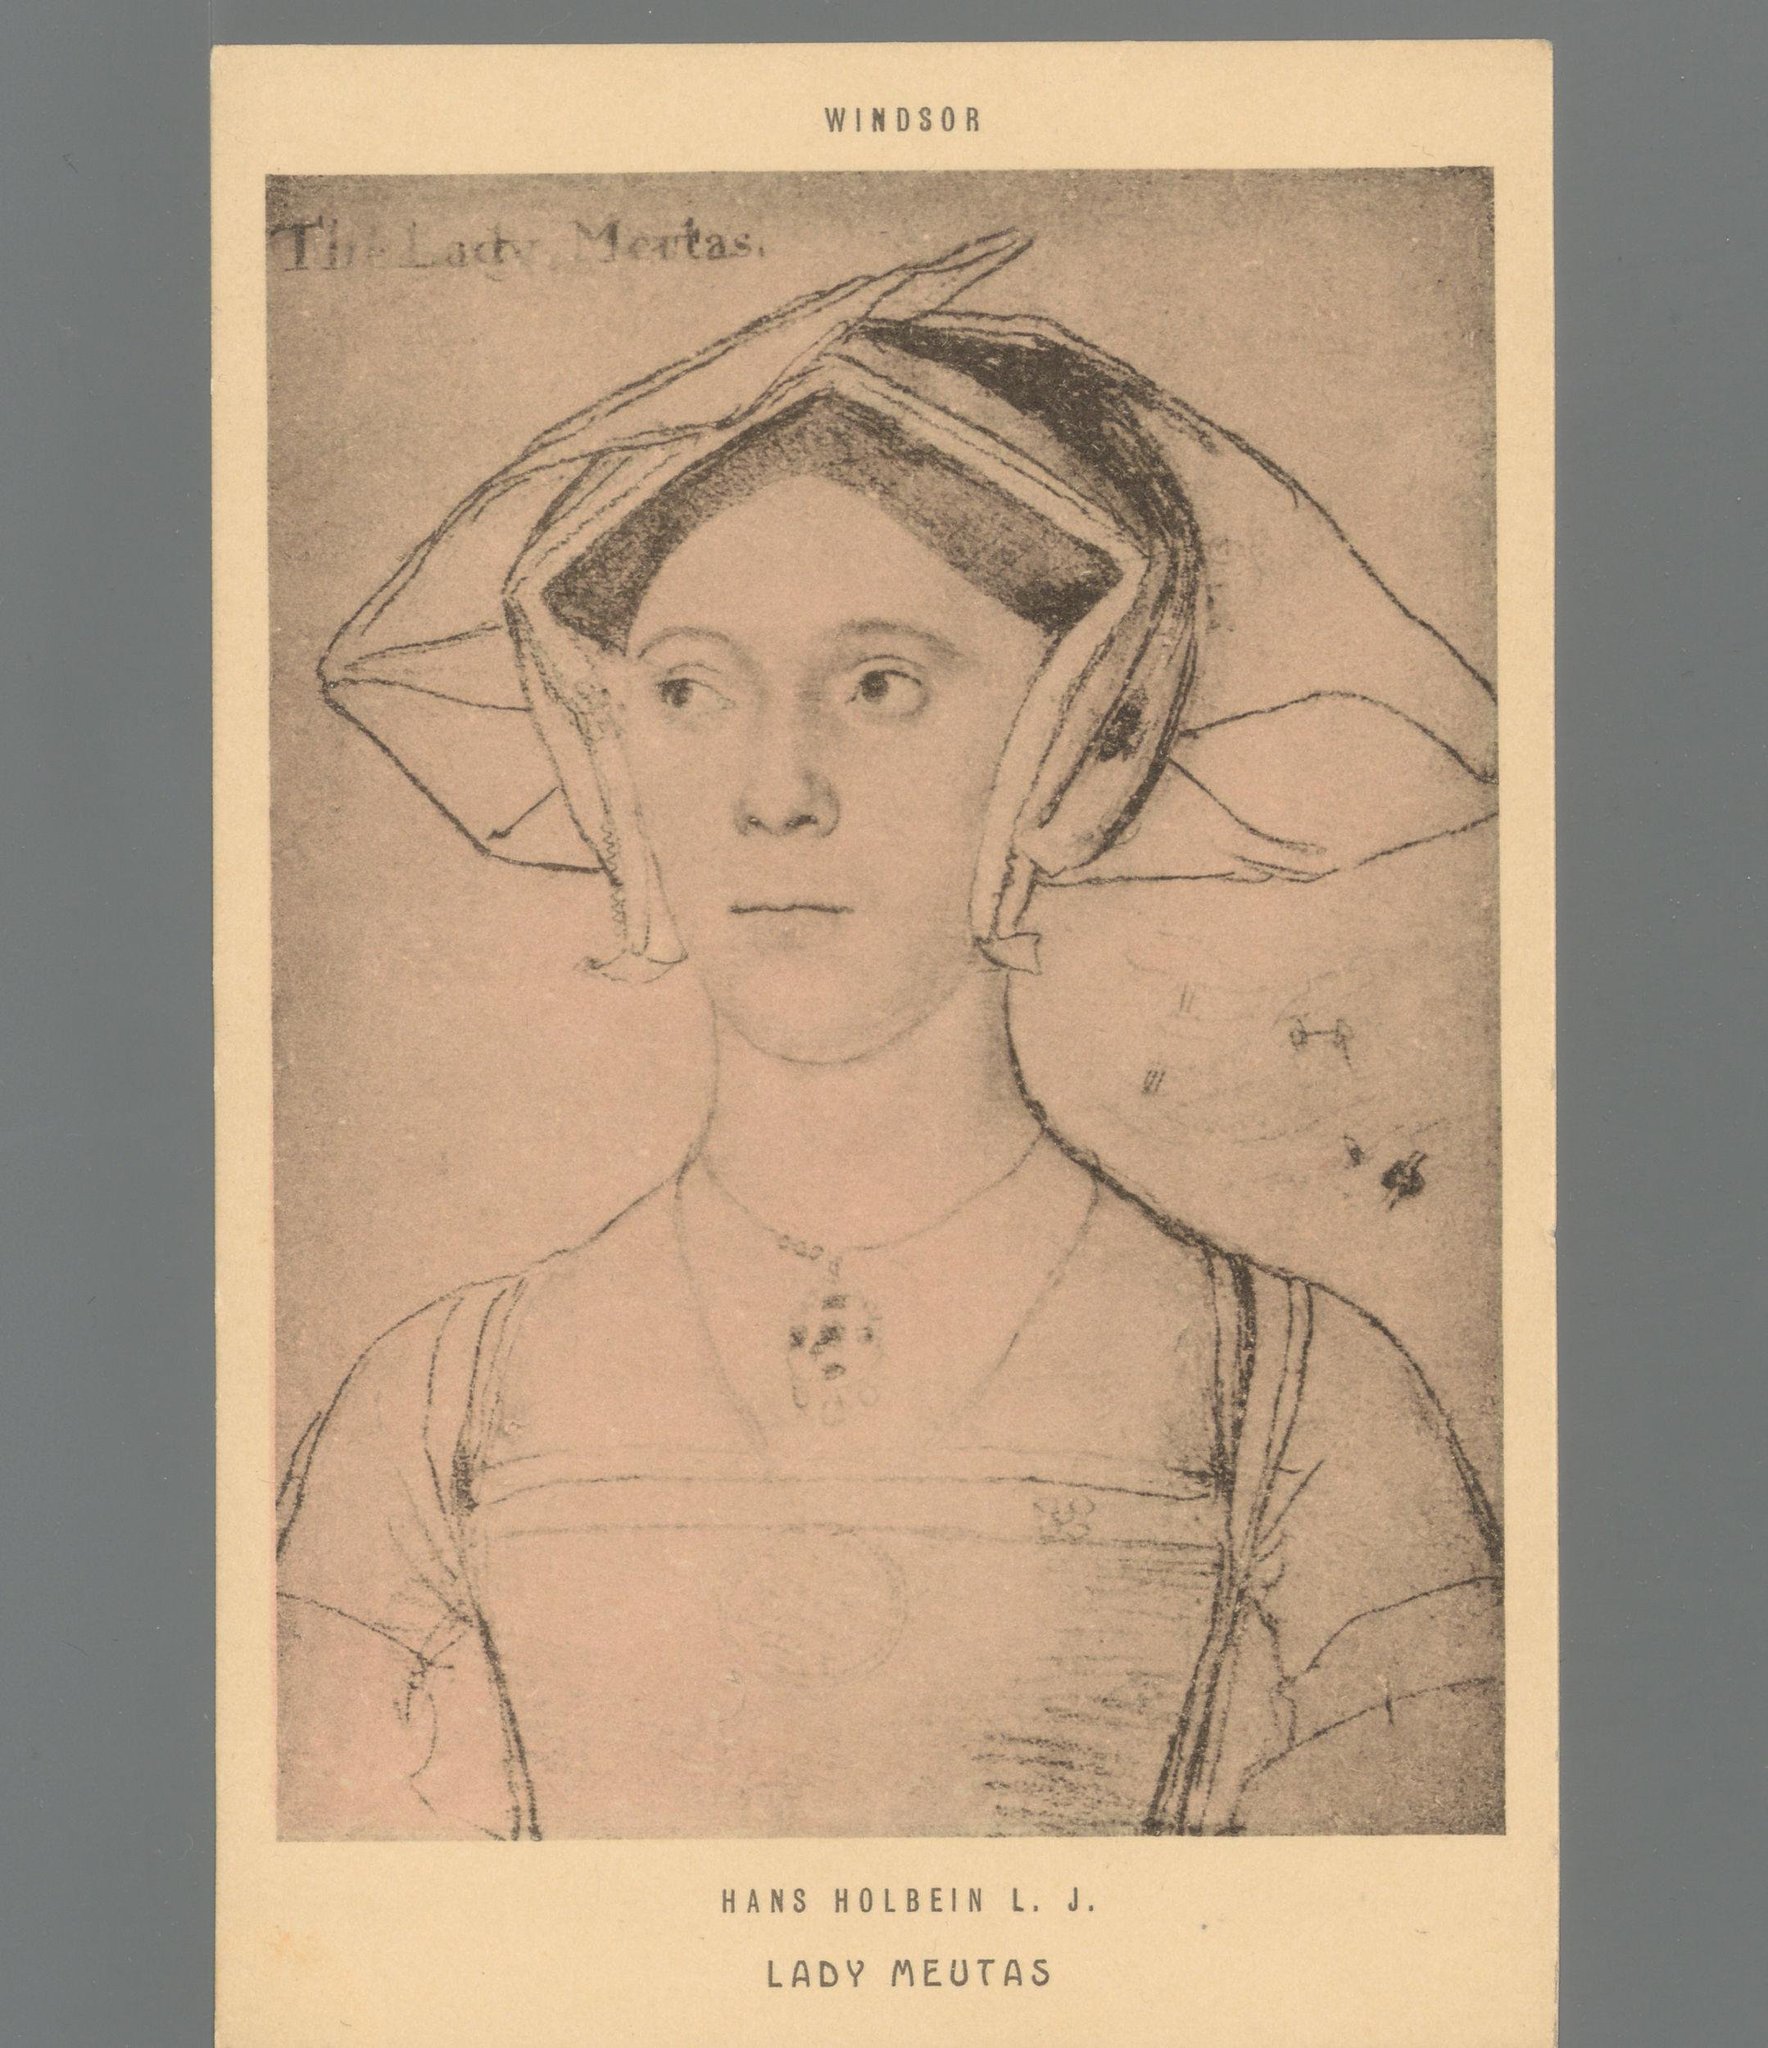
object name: photomechanical print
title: Windsor. Hans Holbein L.J. Lady Meutas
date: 1903-1930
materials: cardboard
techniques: photograph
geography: paris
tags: castle, historical persons - bb - woman, picture, painting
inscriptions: collector's mark: ‘AFE v S’